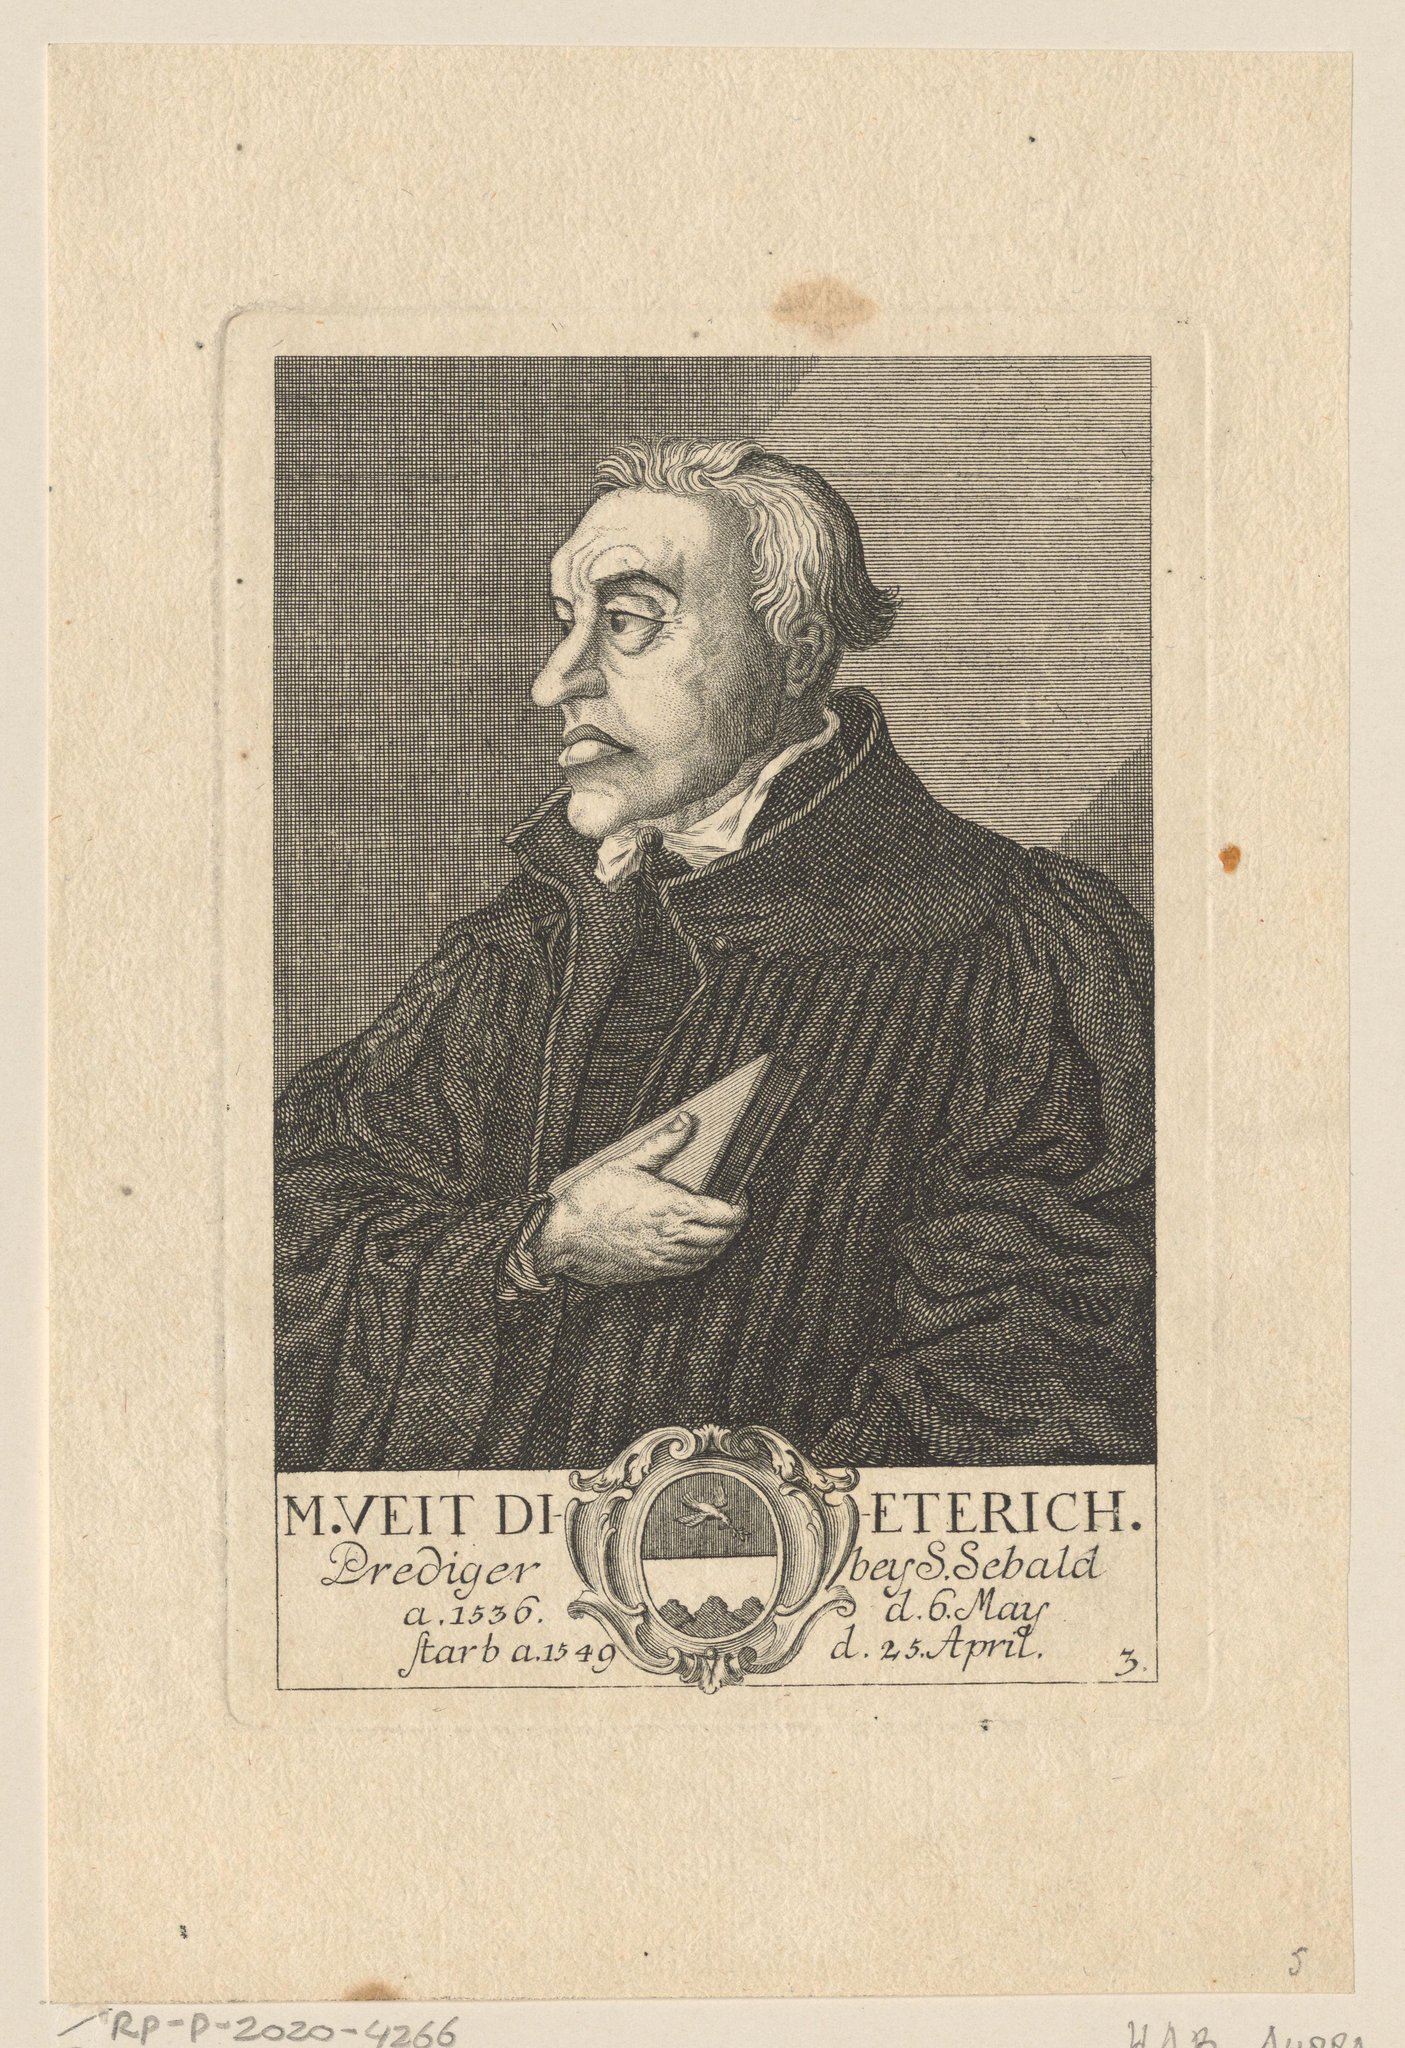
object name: print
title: Portret van Veit Dietrich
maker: Anonymous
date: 1756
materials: paper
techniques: engraving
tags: theologian, historical persons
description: Prent mogelijk uit: Würfel, Andreas. Diptycha ecclesiae Sebaldianae (...). Neurenberg: Christoph Melchior Roth, 1756.